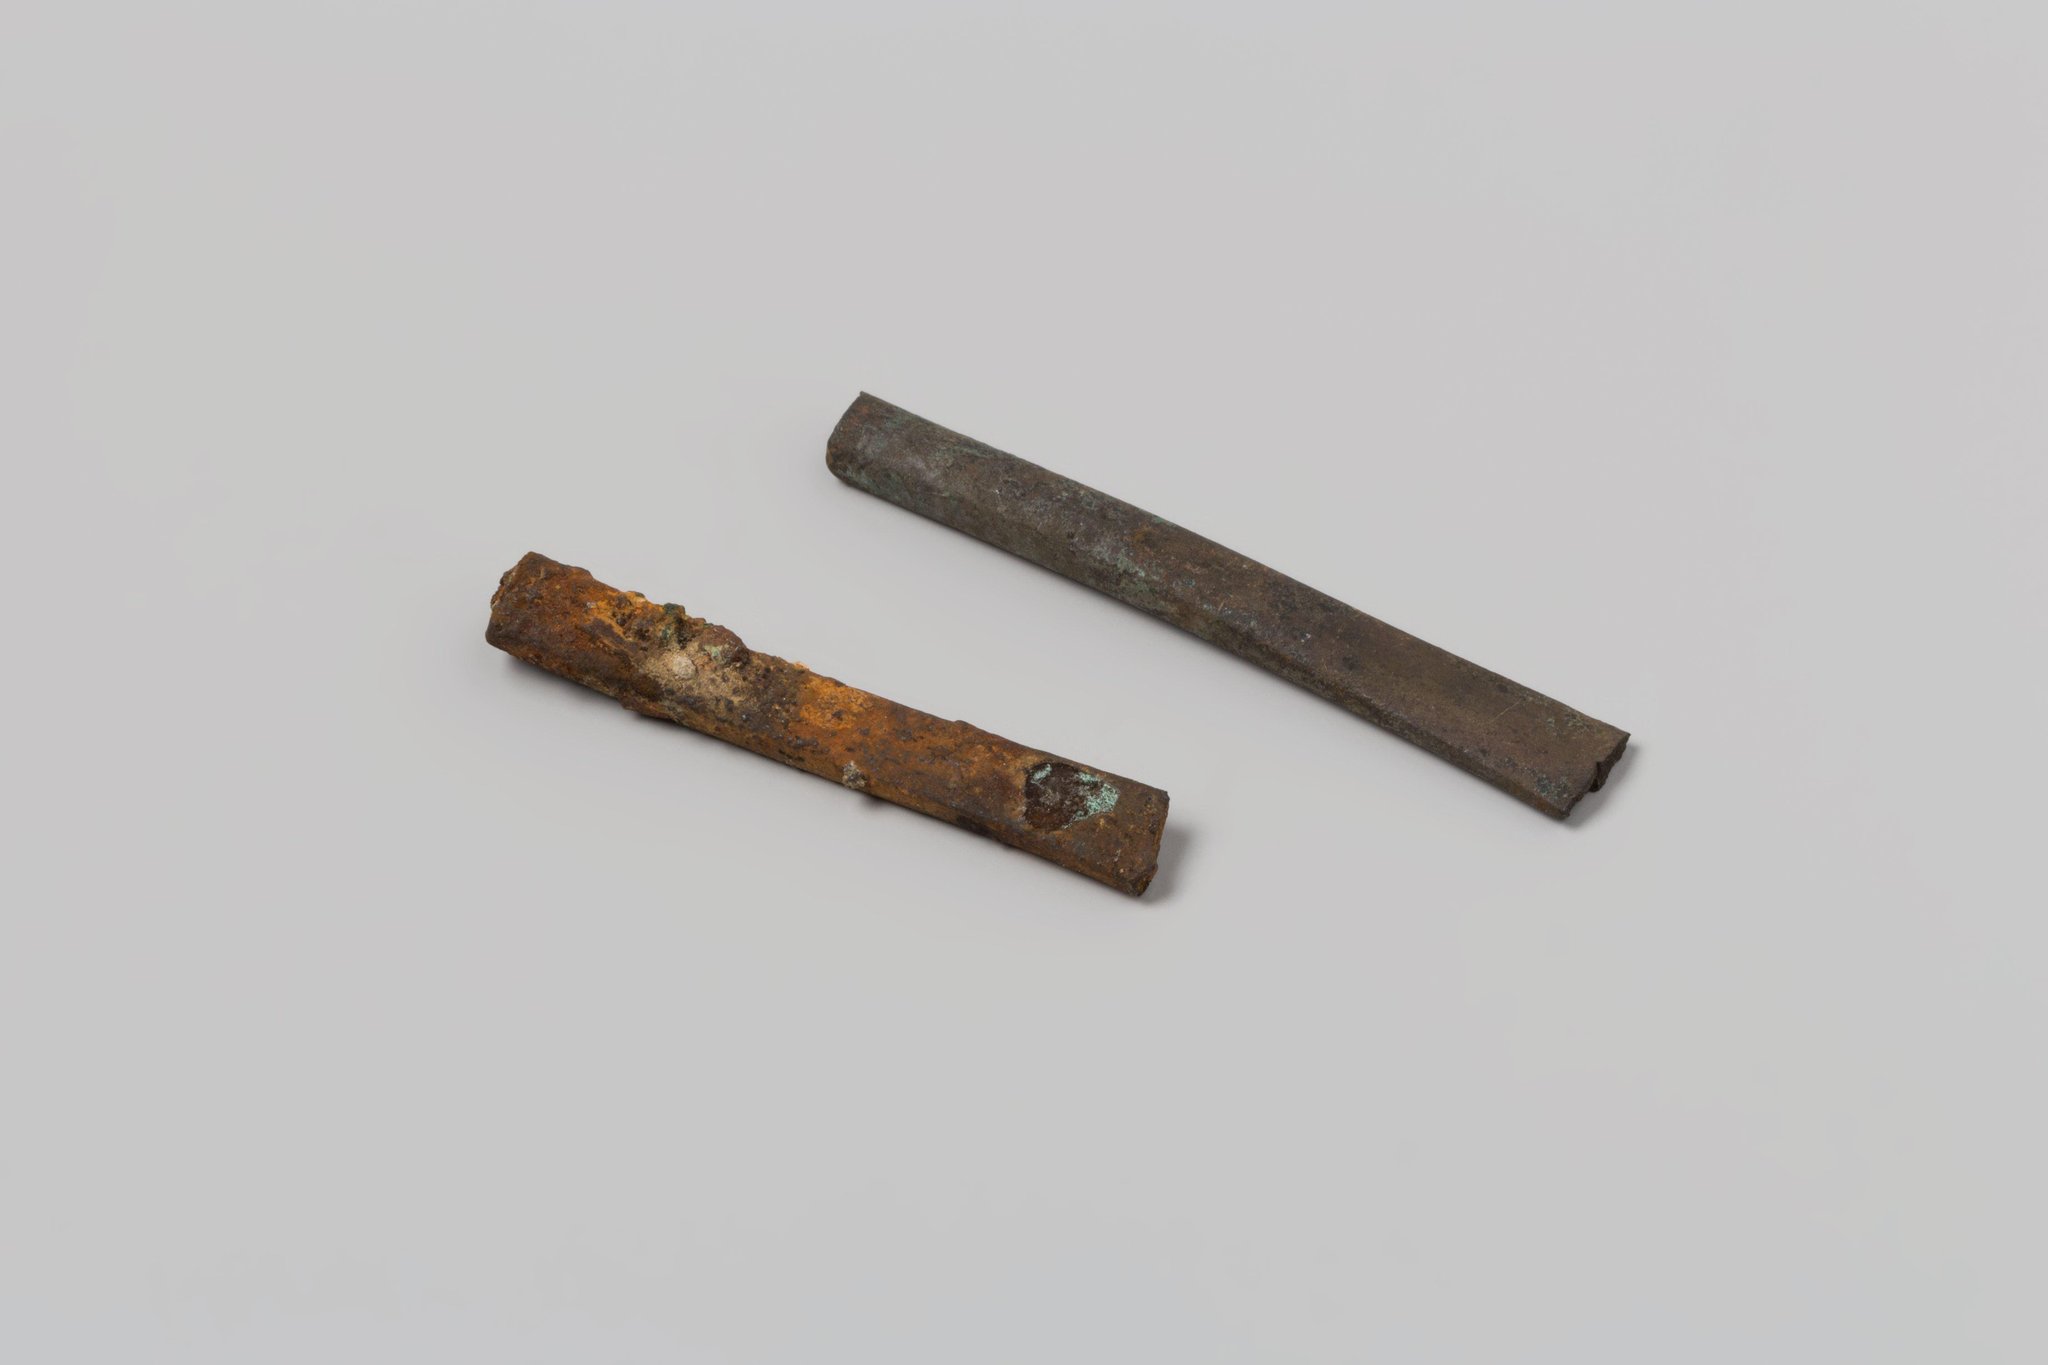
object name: fork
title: Fragmenten stelen van vorken of lepels uit het wrak van de Oost-Indiëvaarder Hollandia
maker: Anonymous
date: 1700-1743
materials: copper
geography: netherlands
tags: verenigde oostindische compagnie, hollandia (schip), annet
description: Cutlery, fragment: stem of fork or spoon; fragm, flat, sim. NG 1980-27H966/656/3366.